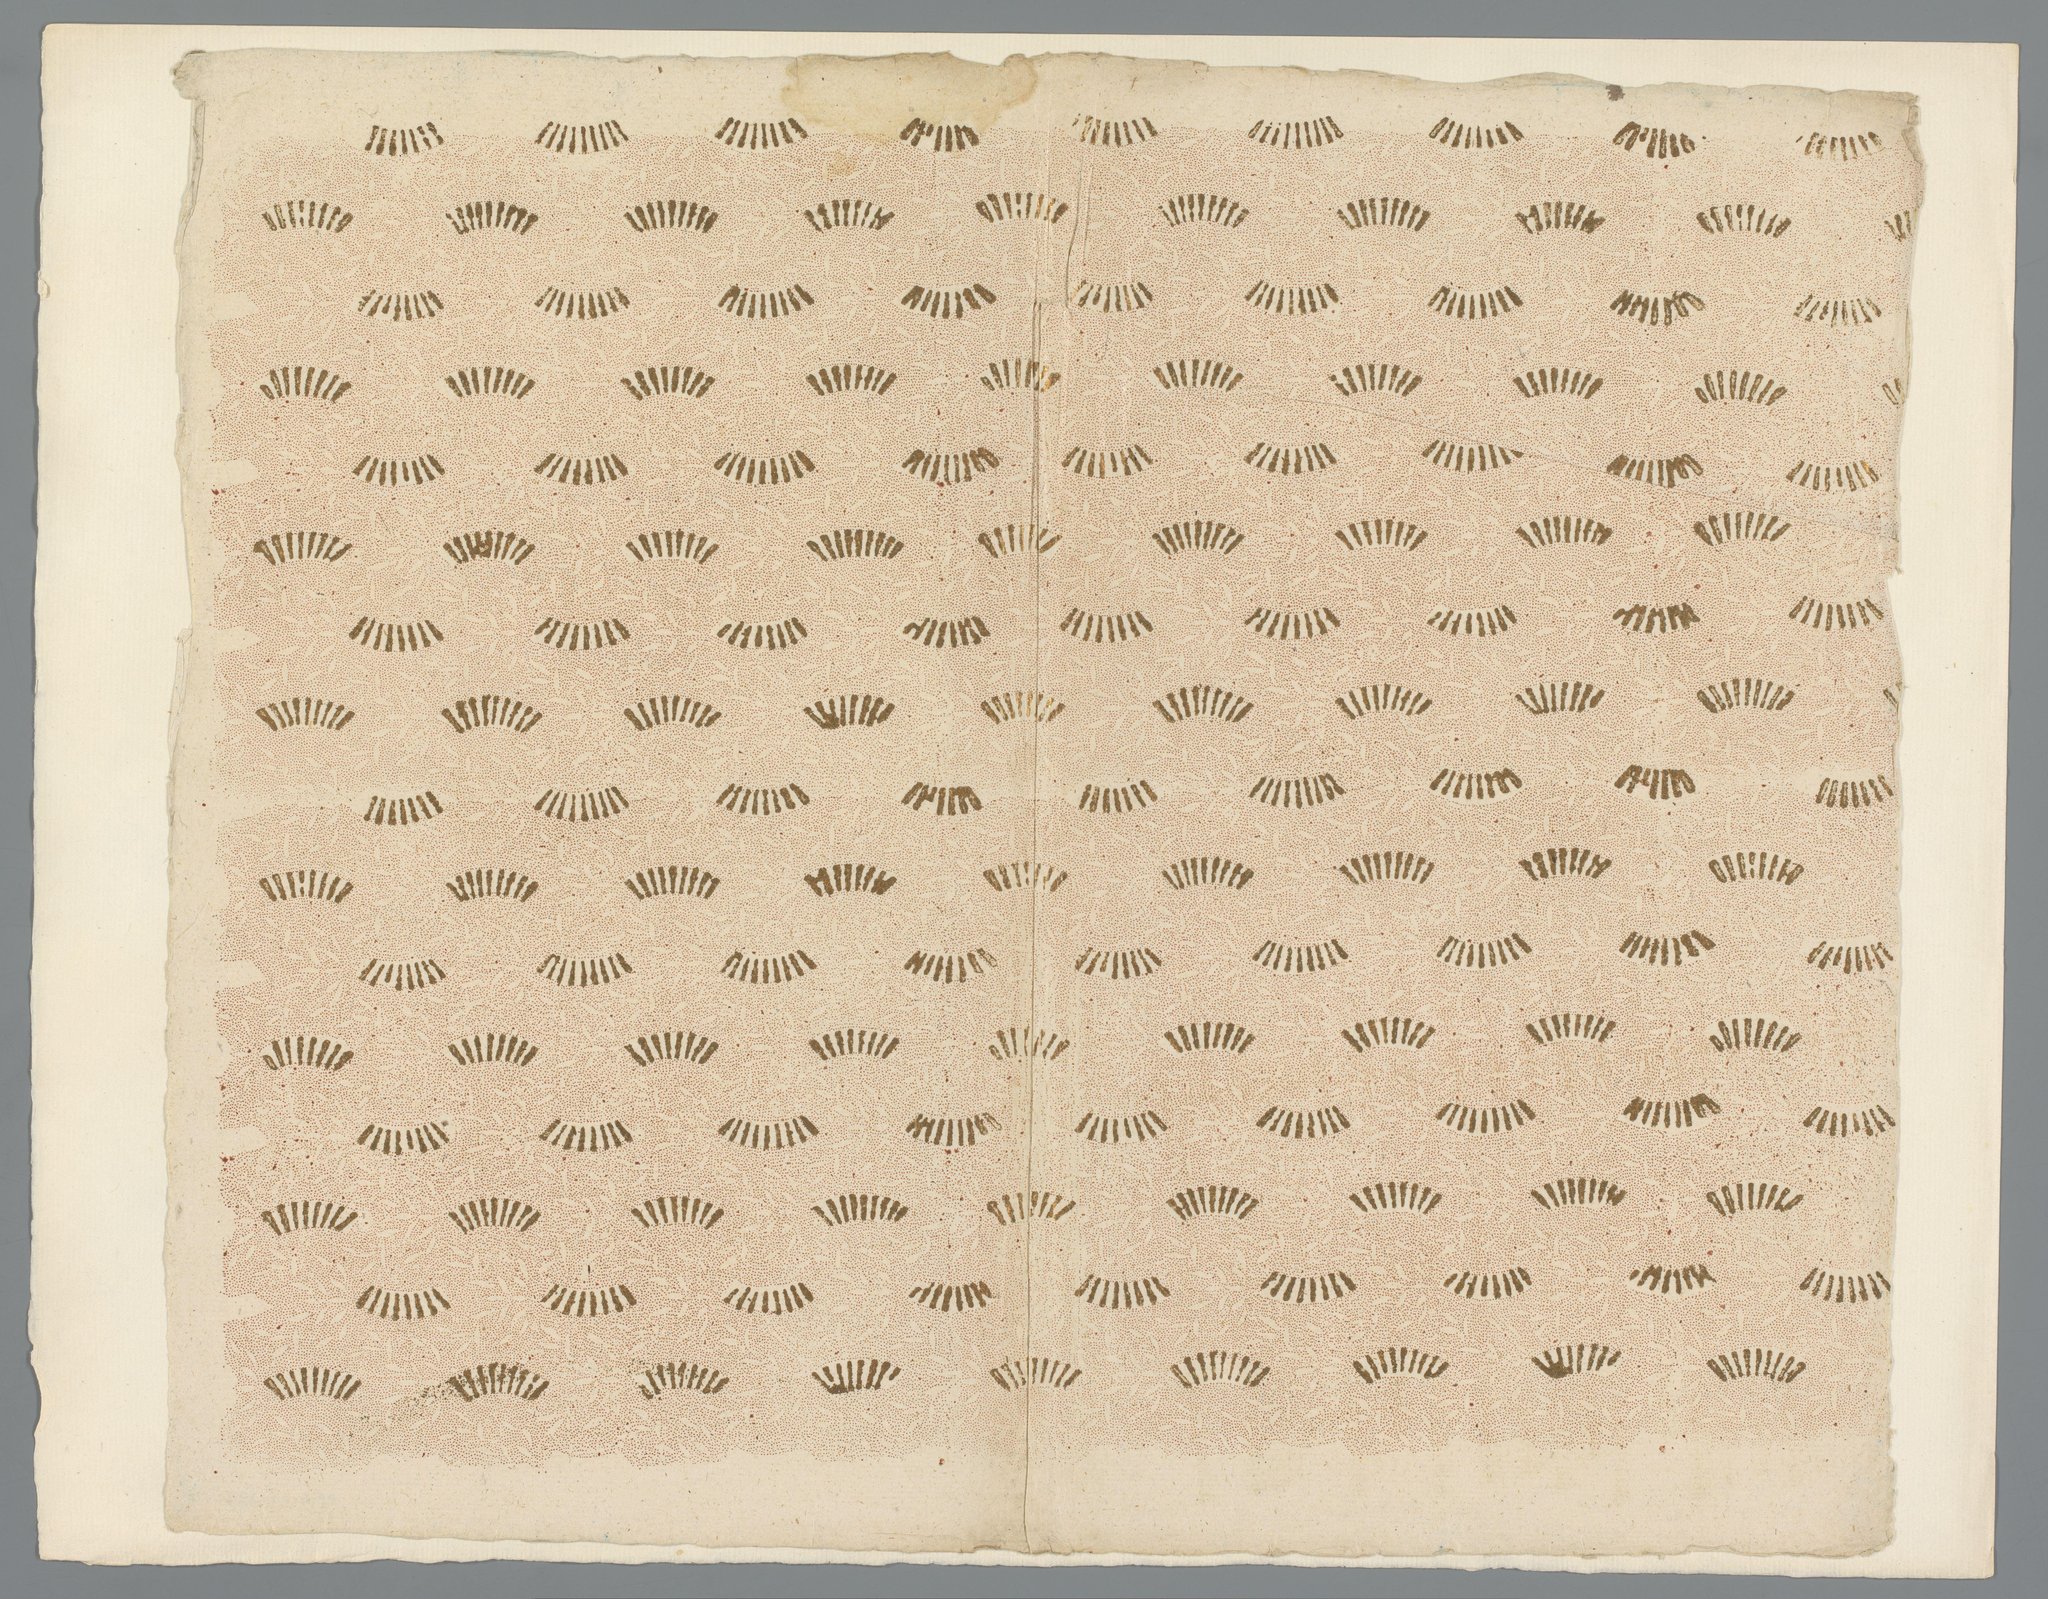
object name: printed paper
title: Blad met strooipatroon van motief met streepjes in een puntenfond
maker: Anonymous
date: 1750-1950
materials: paint, paper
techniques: printing block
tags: fantasy ornament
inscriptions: annotation: ‘Geschenk voor Ned. Museum van JA Frederiks Middelburg’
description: Blad met strooipatroon van een motief met streepjes in een puntenfond waarin uitgespaarde bladmotieven. Gebruikt als omslag.